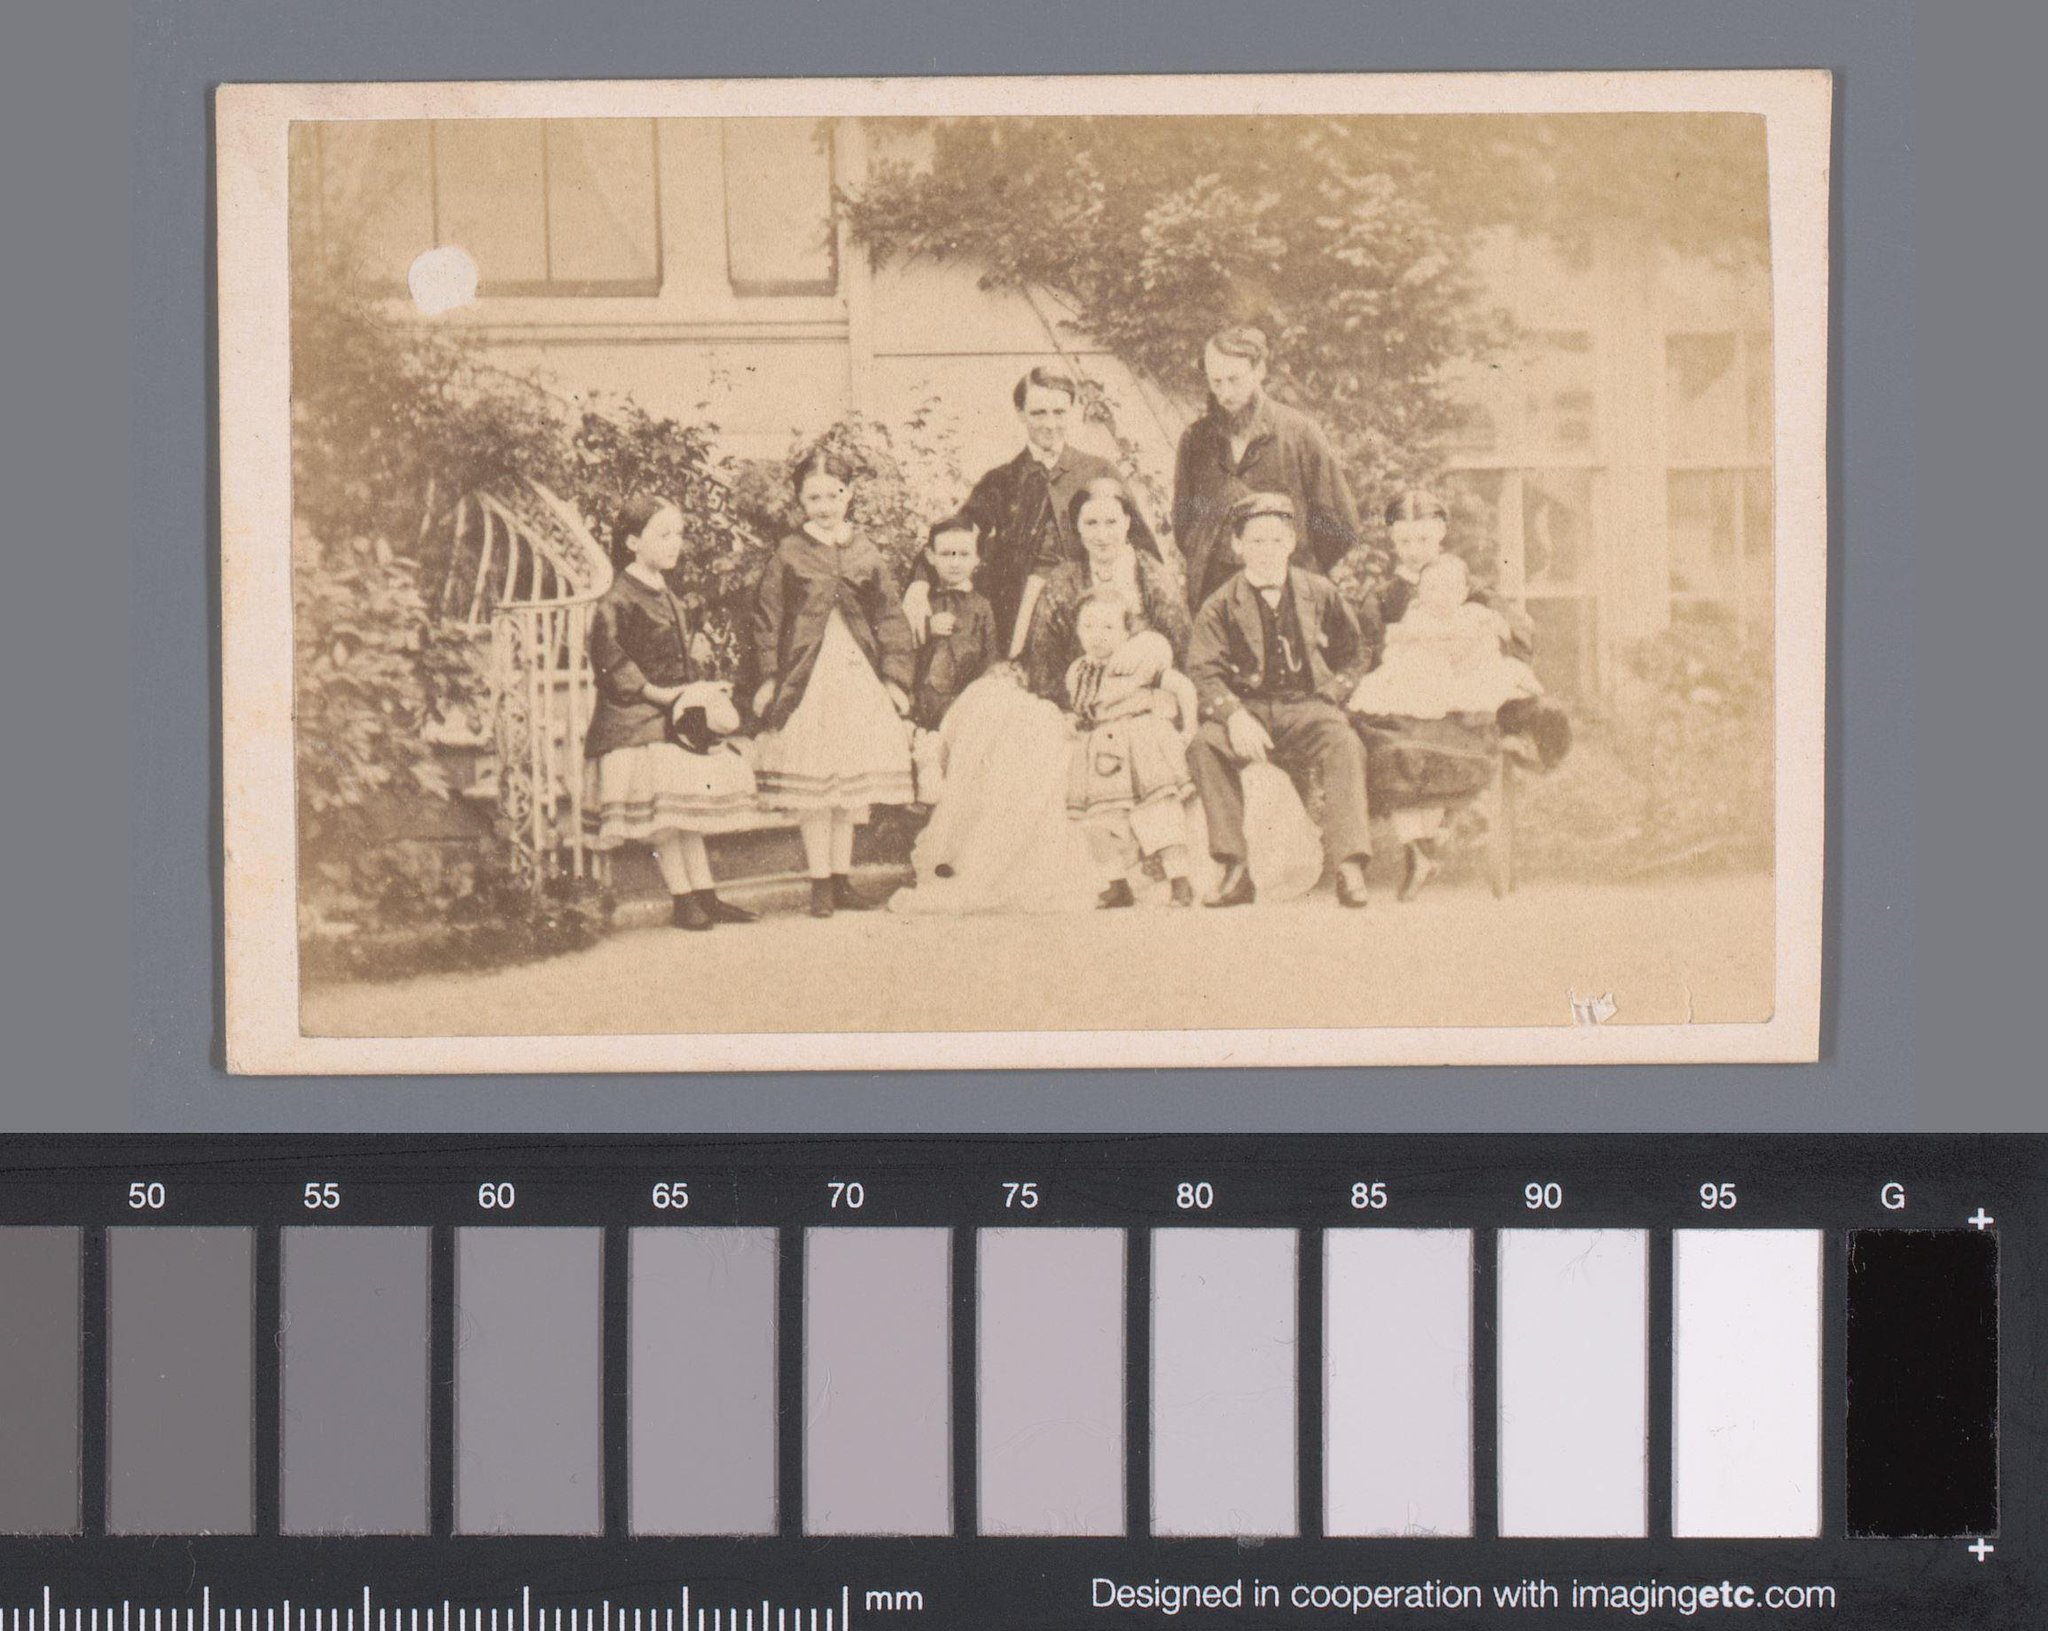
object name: photograph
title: Groepsportret van een onbekende familie voor een huis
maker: francisco sargent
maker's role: fotograaf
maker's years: 1847-1925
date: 1861-1865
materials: cardboard, paper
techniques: albumen print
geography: london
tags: family group, especially parents with their child(ren), anonymous historical person portrayed, london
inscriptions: inscription: ‘Photographed by/ F. Sargent/ 25, Pavement Clapham/ 7/ Derby House West Brixton/ S.’